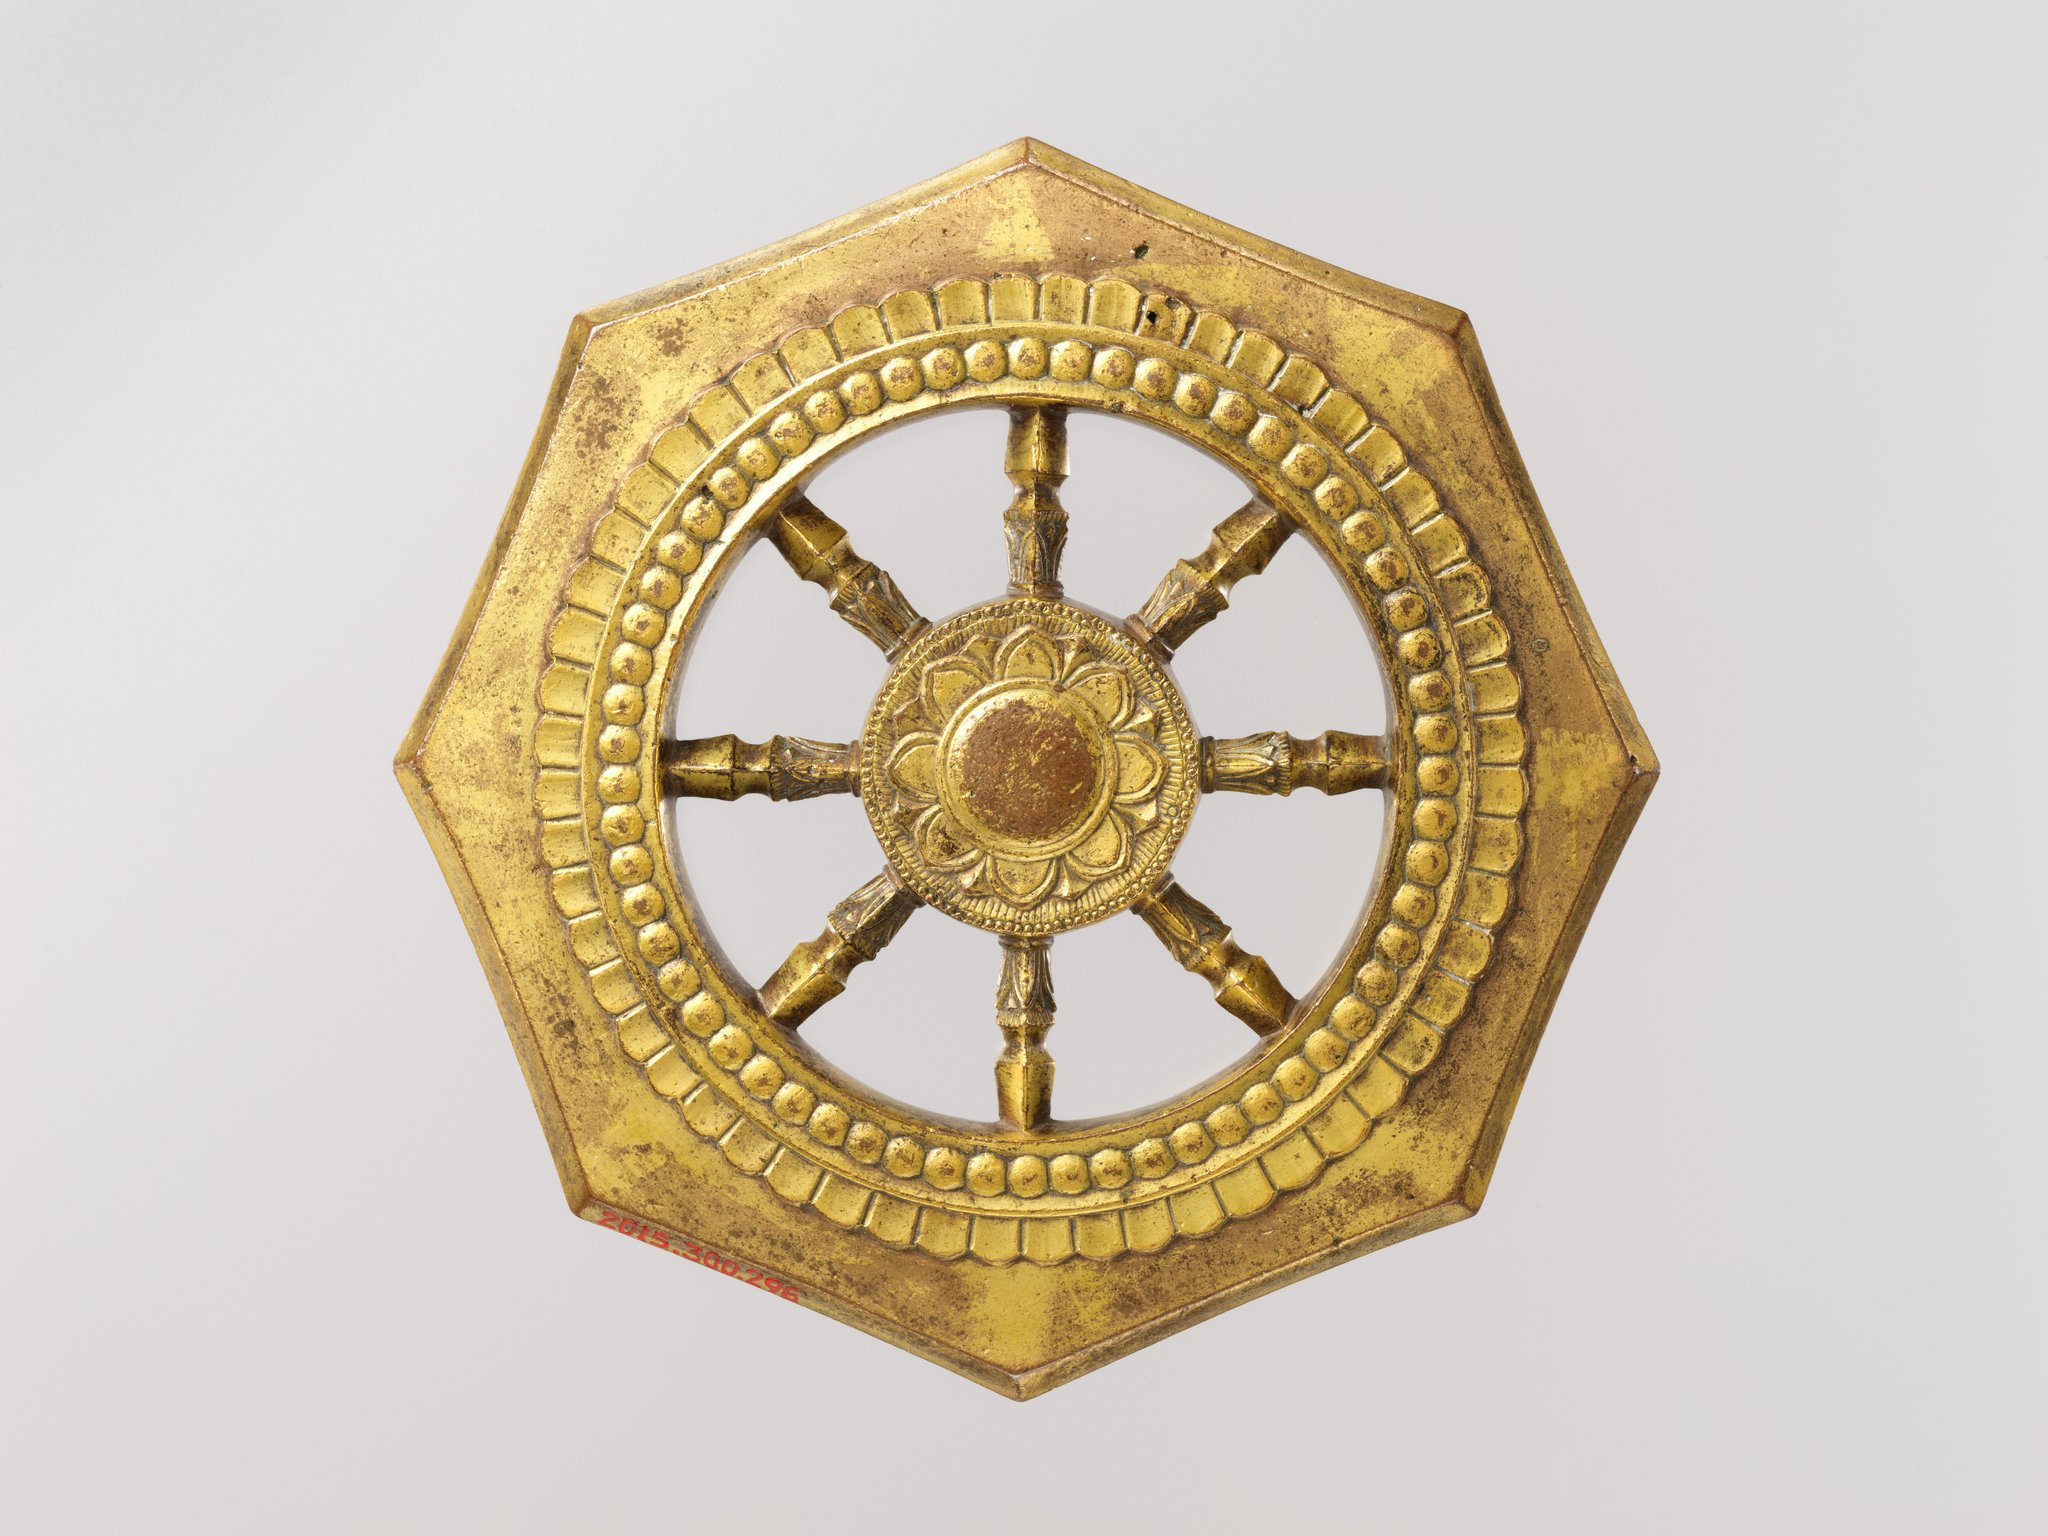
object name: chakra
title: Wheel of the Buddhist Law (Rinpō)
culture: japanese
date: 1267-1300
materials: gilt bronze